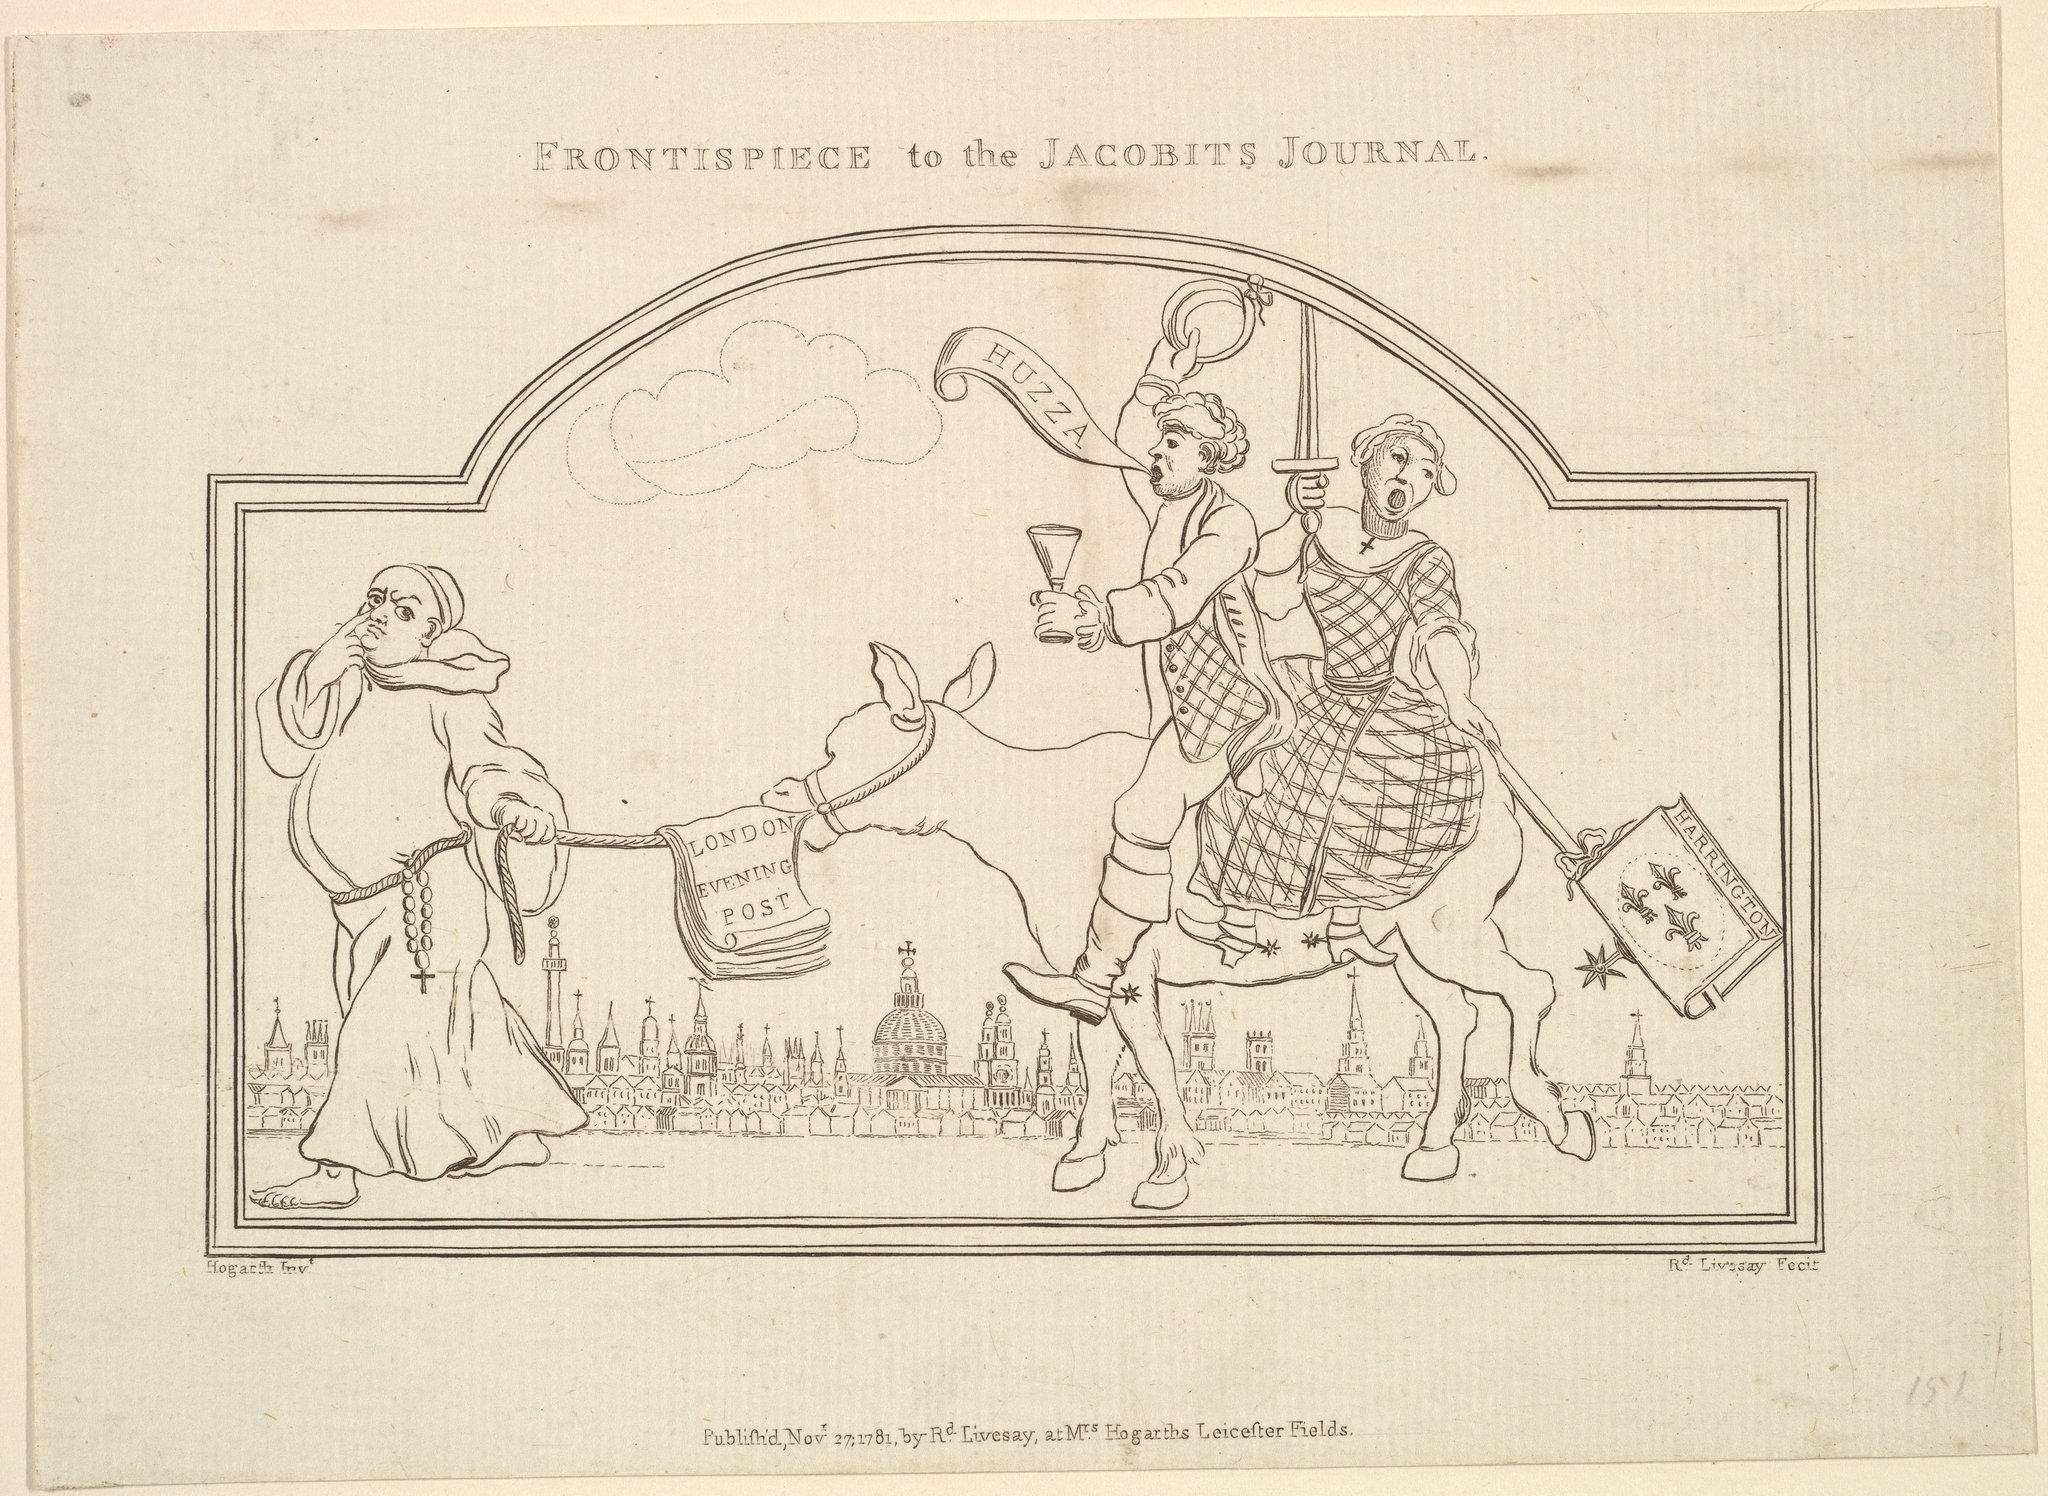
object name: print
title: Frontispiece to "The Jacobite's Journal"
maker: richard livesay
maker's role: artist and publisher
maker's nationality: british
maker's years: 1750-1826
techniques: engraving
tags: men,women,donkeys,monks